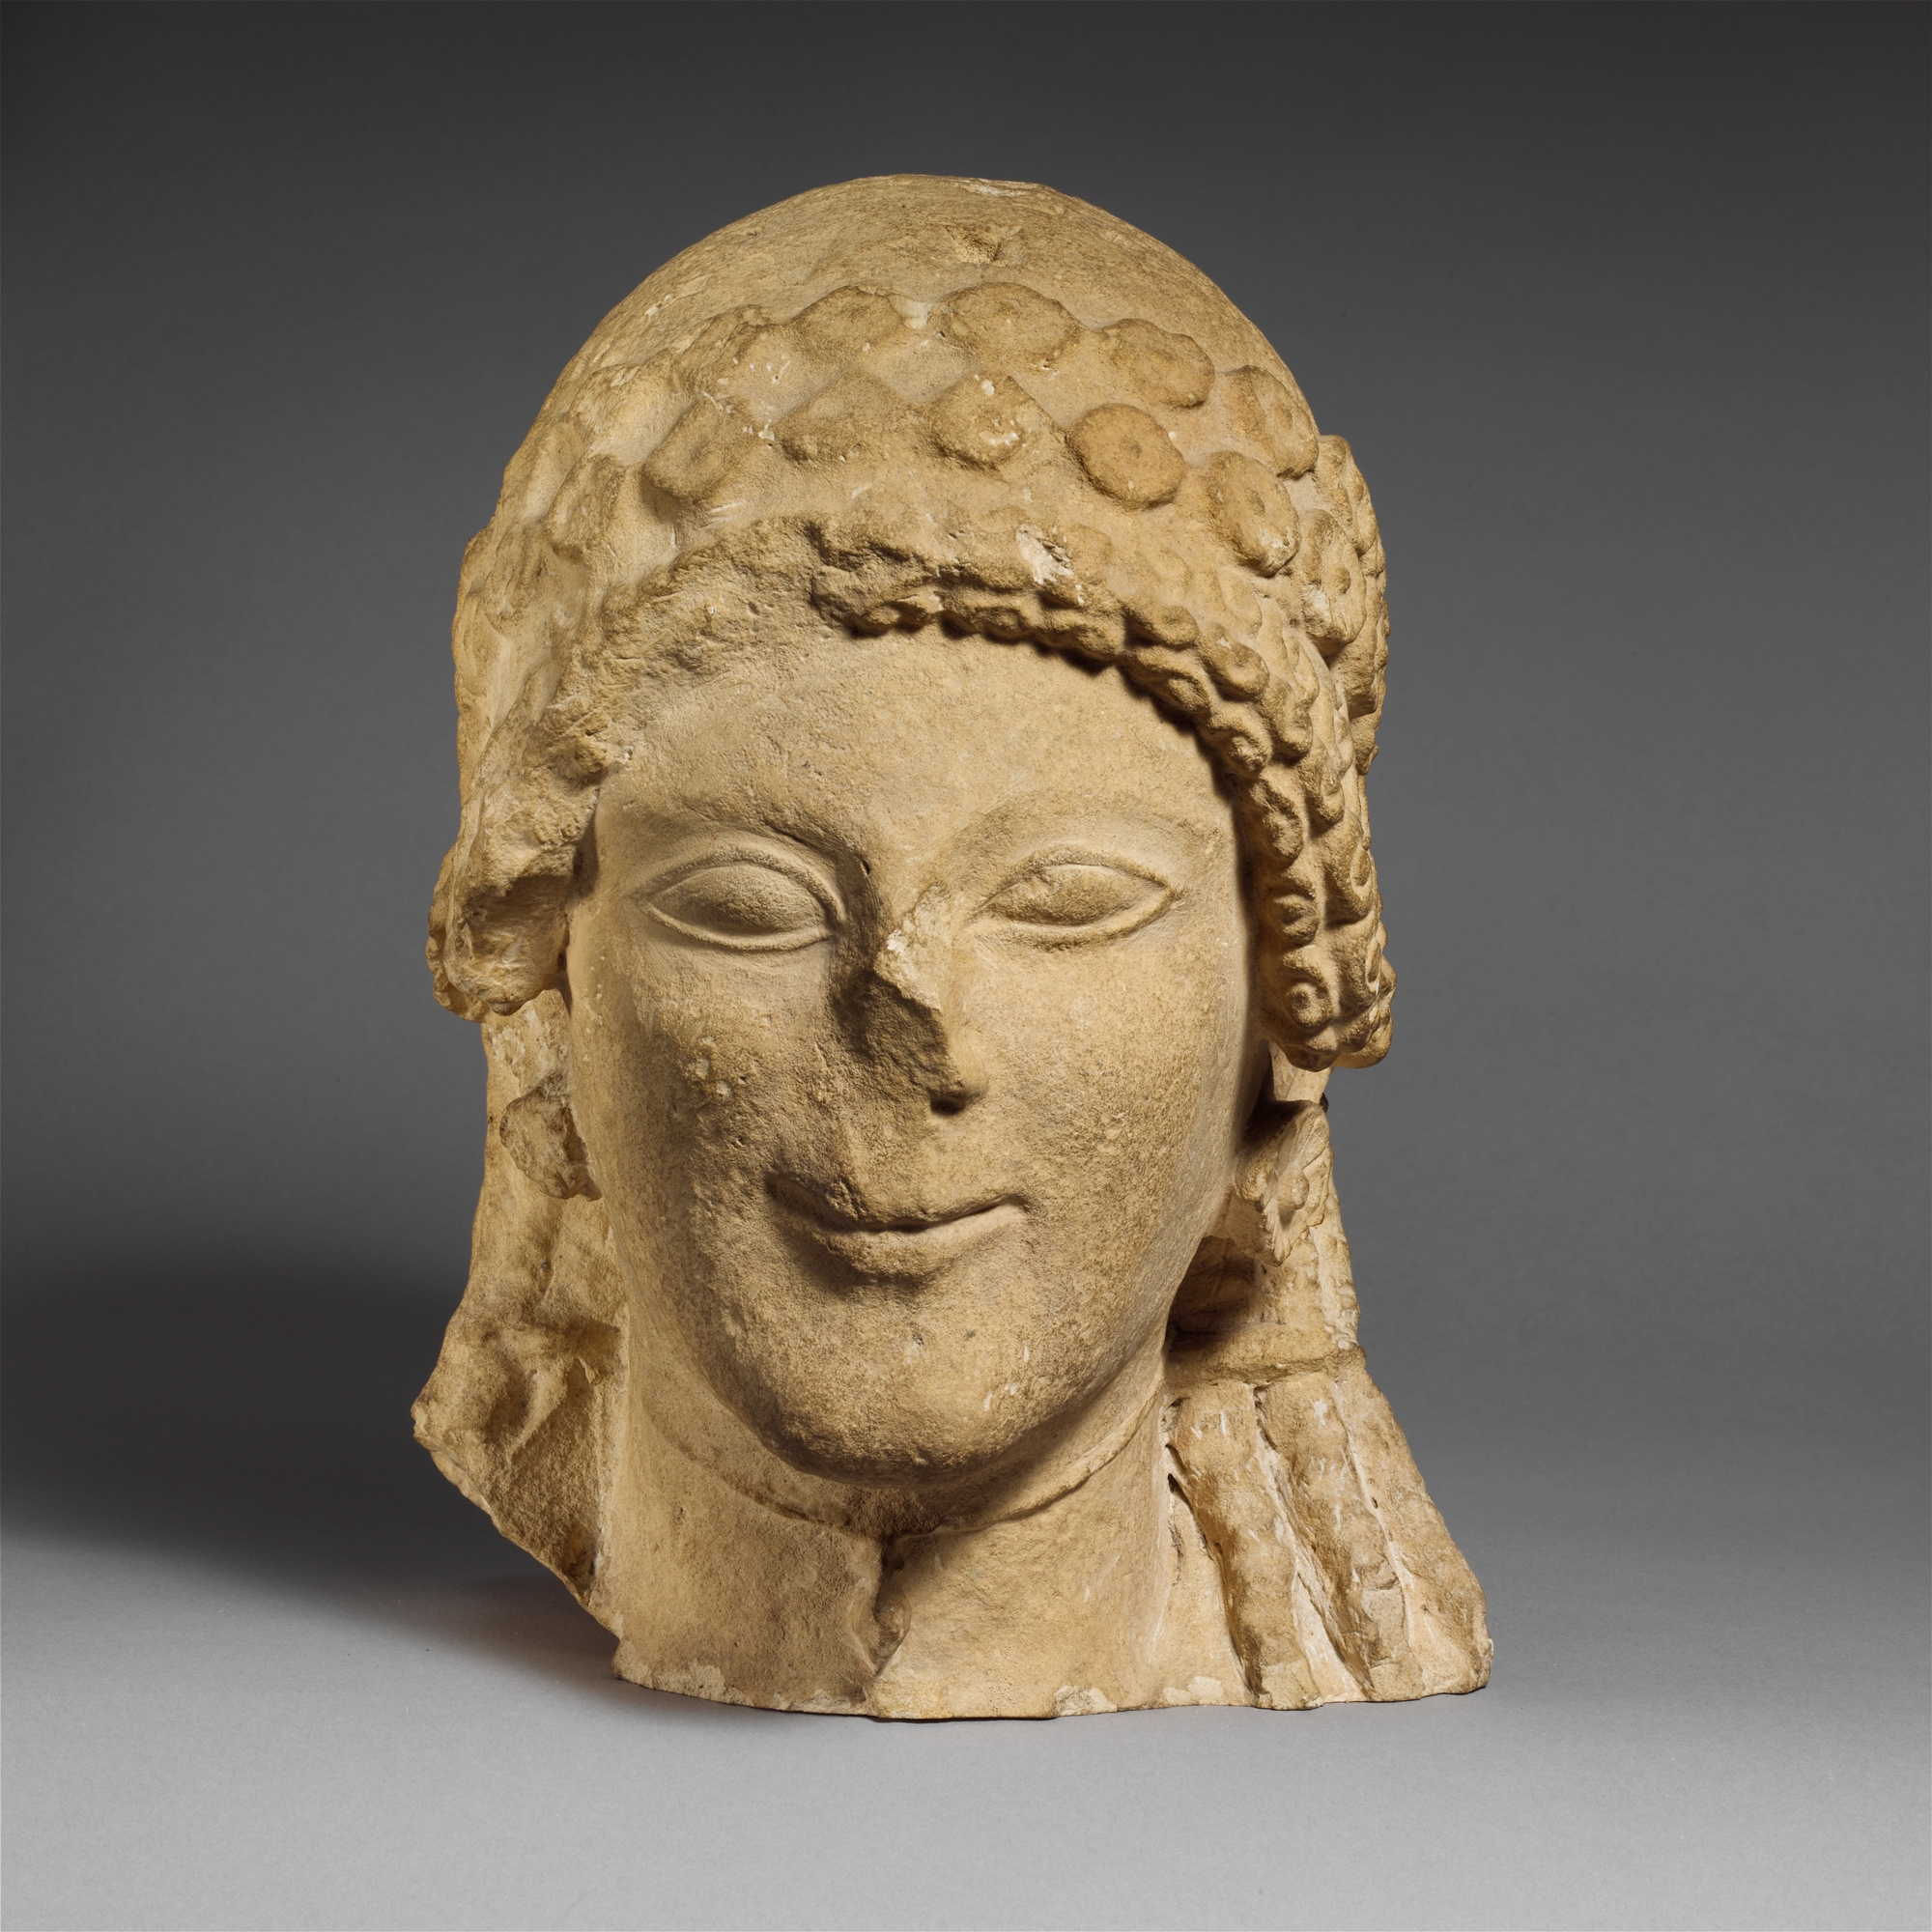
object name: head of a woman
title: Limestone head of a female votary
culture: cypriot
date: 500-468 BCE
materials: limestone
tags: earrings,necklaces,heads,women